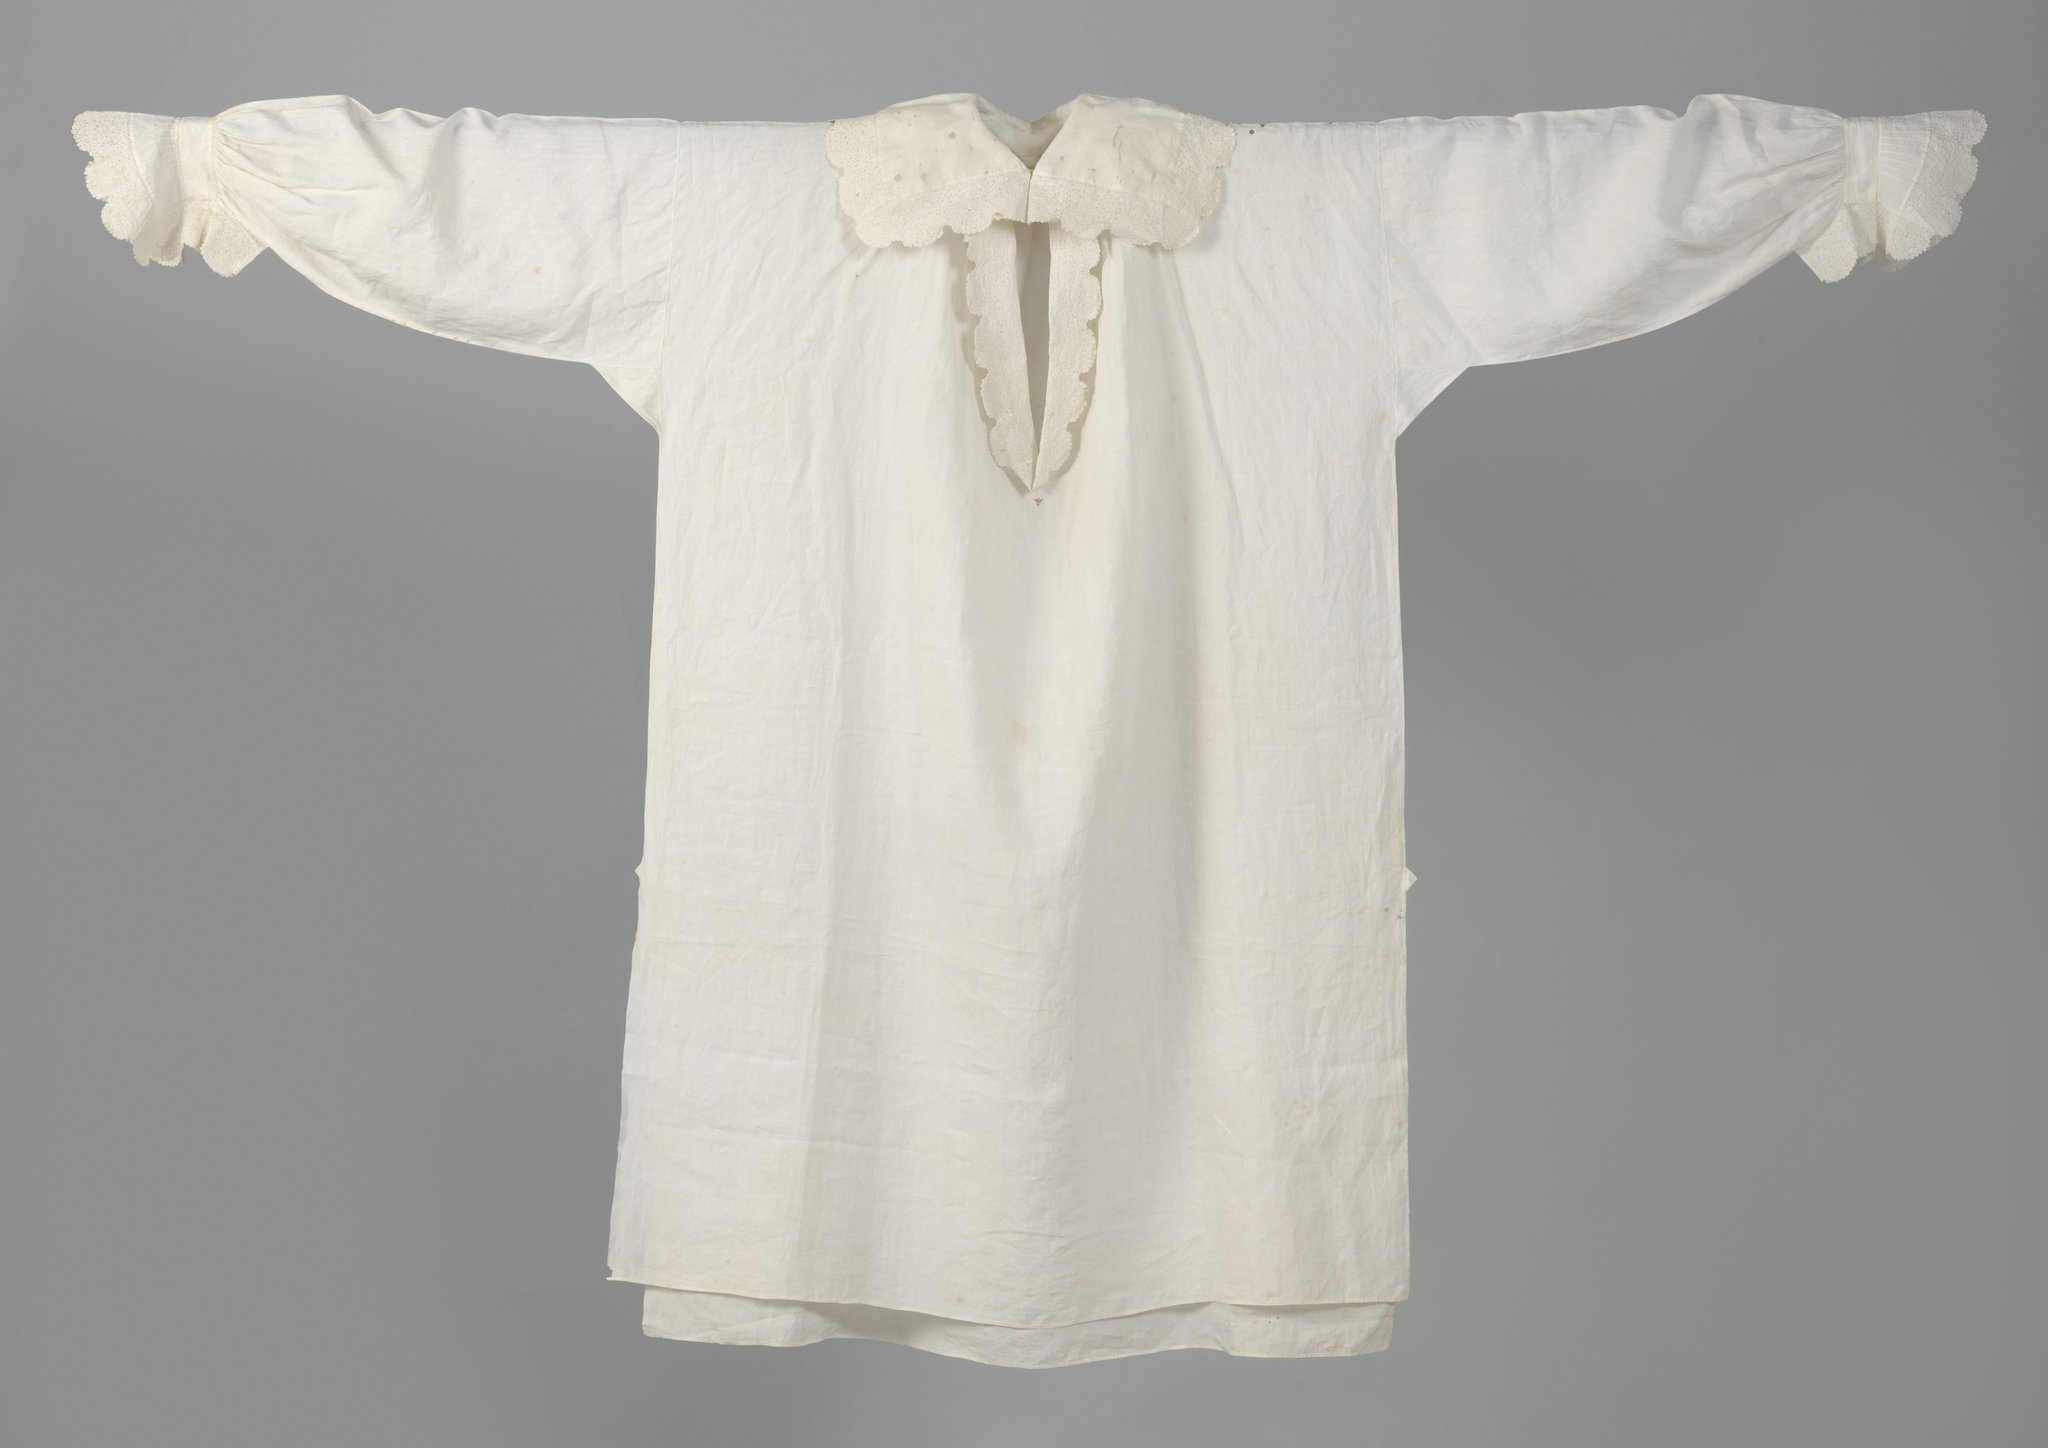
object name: menswear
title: Shirt of Willem Frederik (?)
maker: Anonymous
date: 1650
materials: linen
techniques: lace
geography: southern netherlands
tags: william ii (prince of orange)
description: In the 17th century, an impeccably clean shirt stood for ‘cleanliness’ (hygiene) and was a status symbol, as clean linens required clear water and an extensive wardrobe. This shirt is decorated with wide flounces of bobbin lace, which only the wealthiest could have afforded. The presumed wearer, Willem Frederik, became Prince of Orange in 1645.